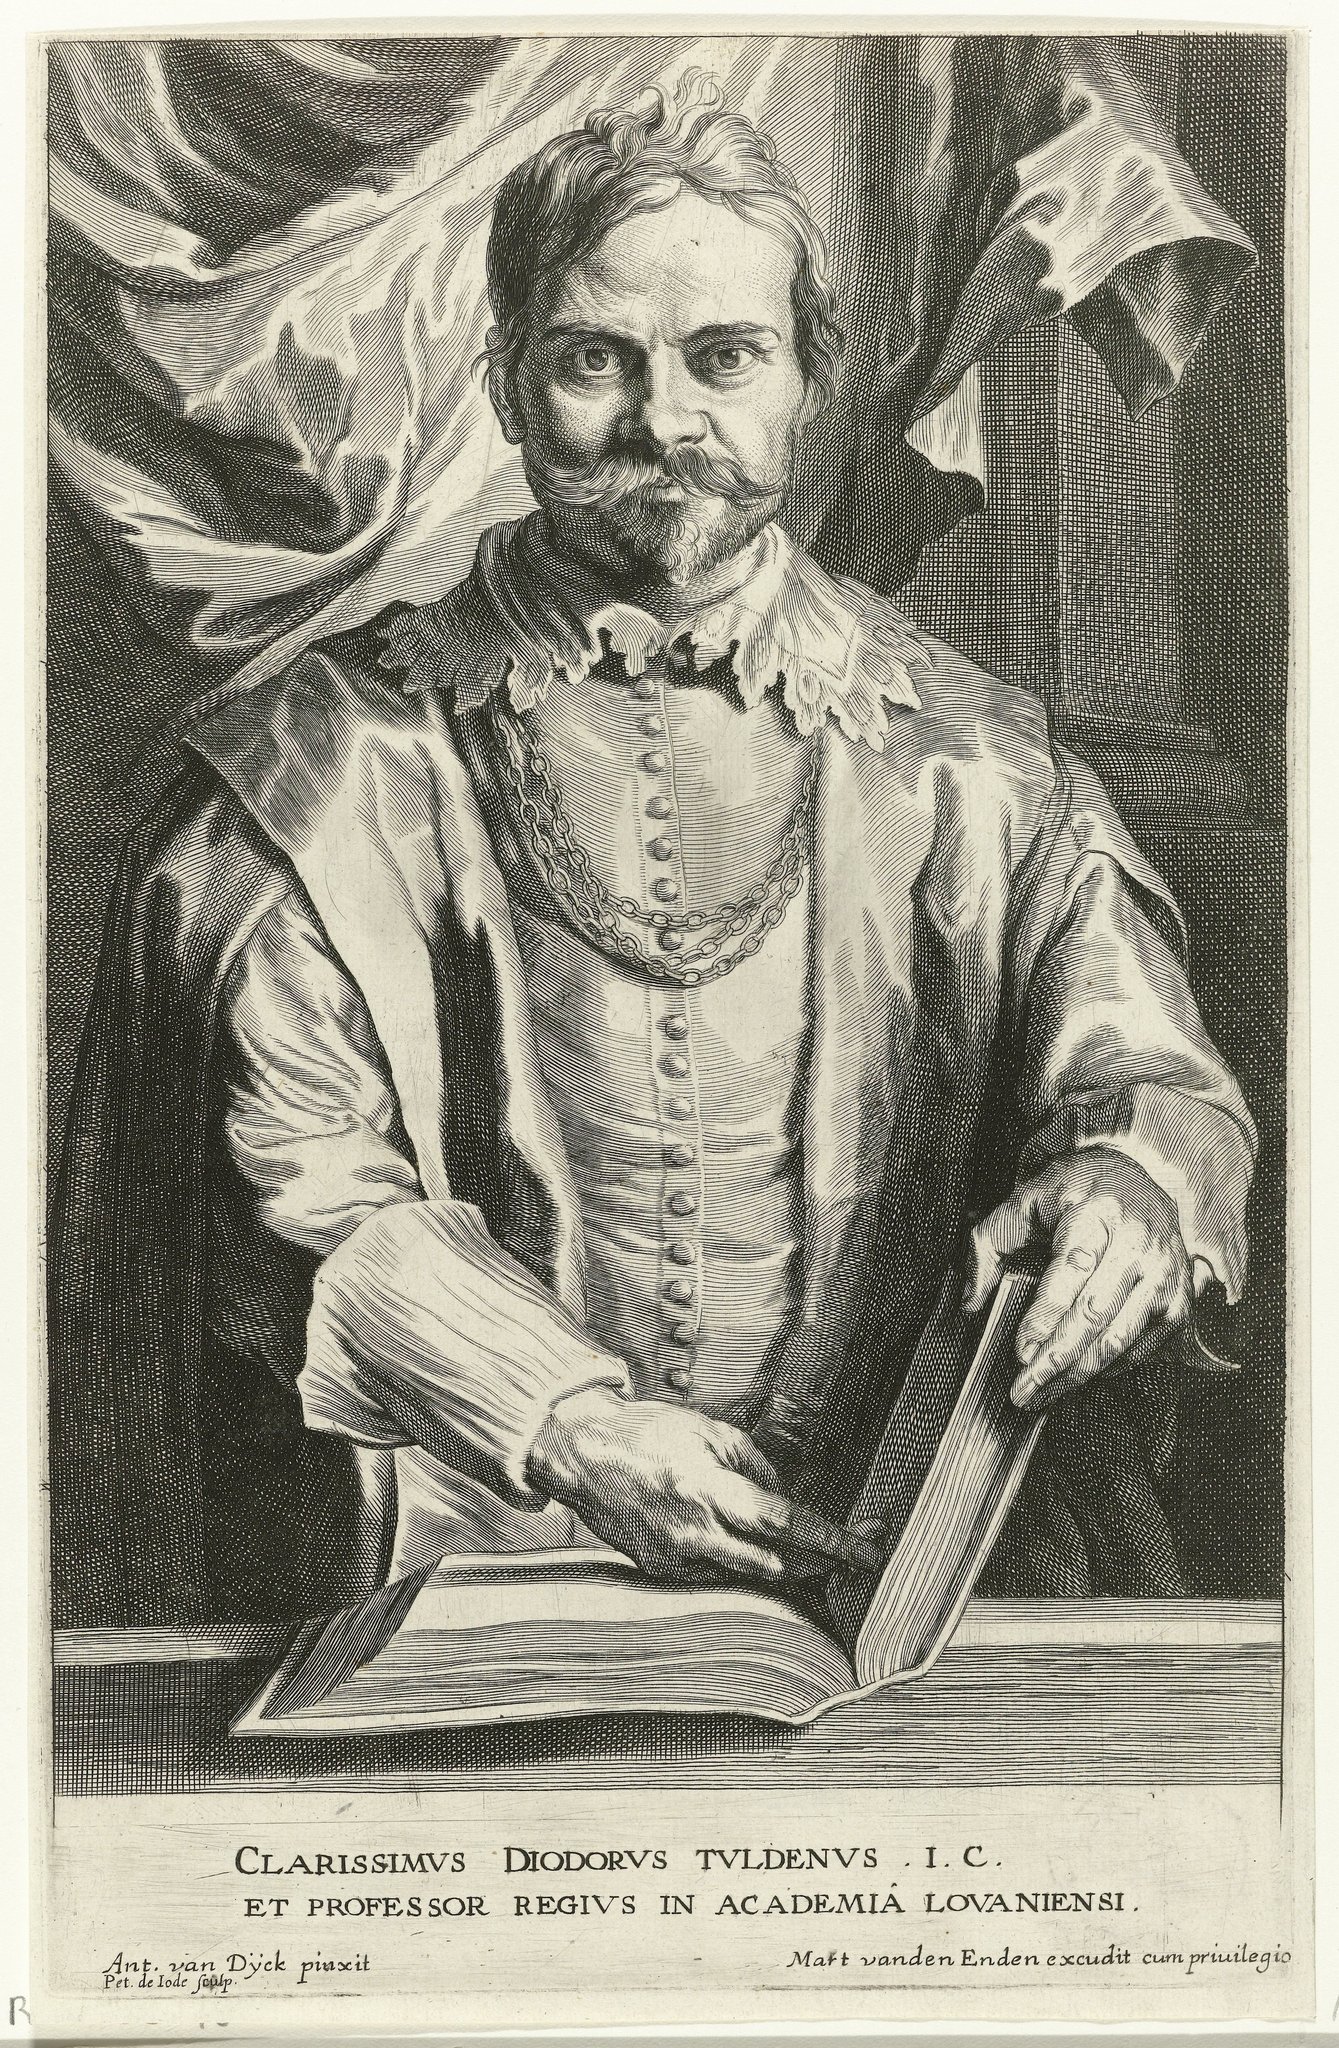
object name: print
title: Portret van Theodore van Tulden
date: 1628-1670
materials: paper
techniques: engraving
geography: antwerp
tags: book - mm - book open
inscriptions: collector's mark: Lugt 240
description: Portret van Theodore van Tulden, ten halven lijve. Hij staat voor een tafel met daarop een opengeslagen boek. Met zijn rechterhand wijst hij op een bladzijde. In de marge een tweeregelig onderschrift in het Latijn.